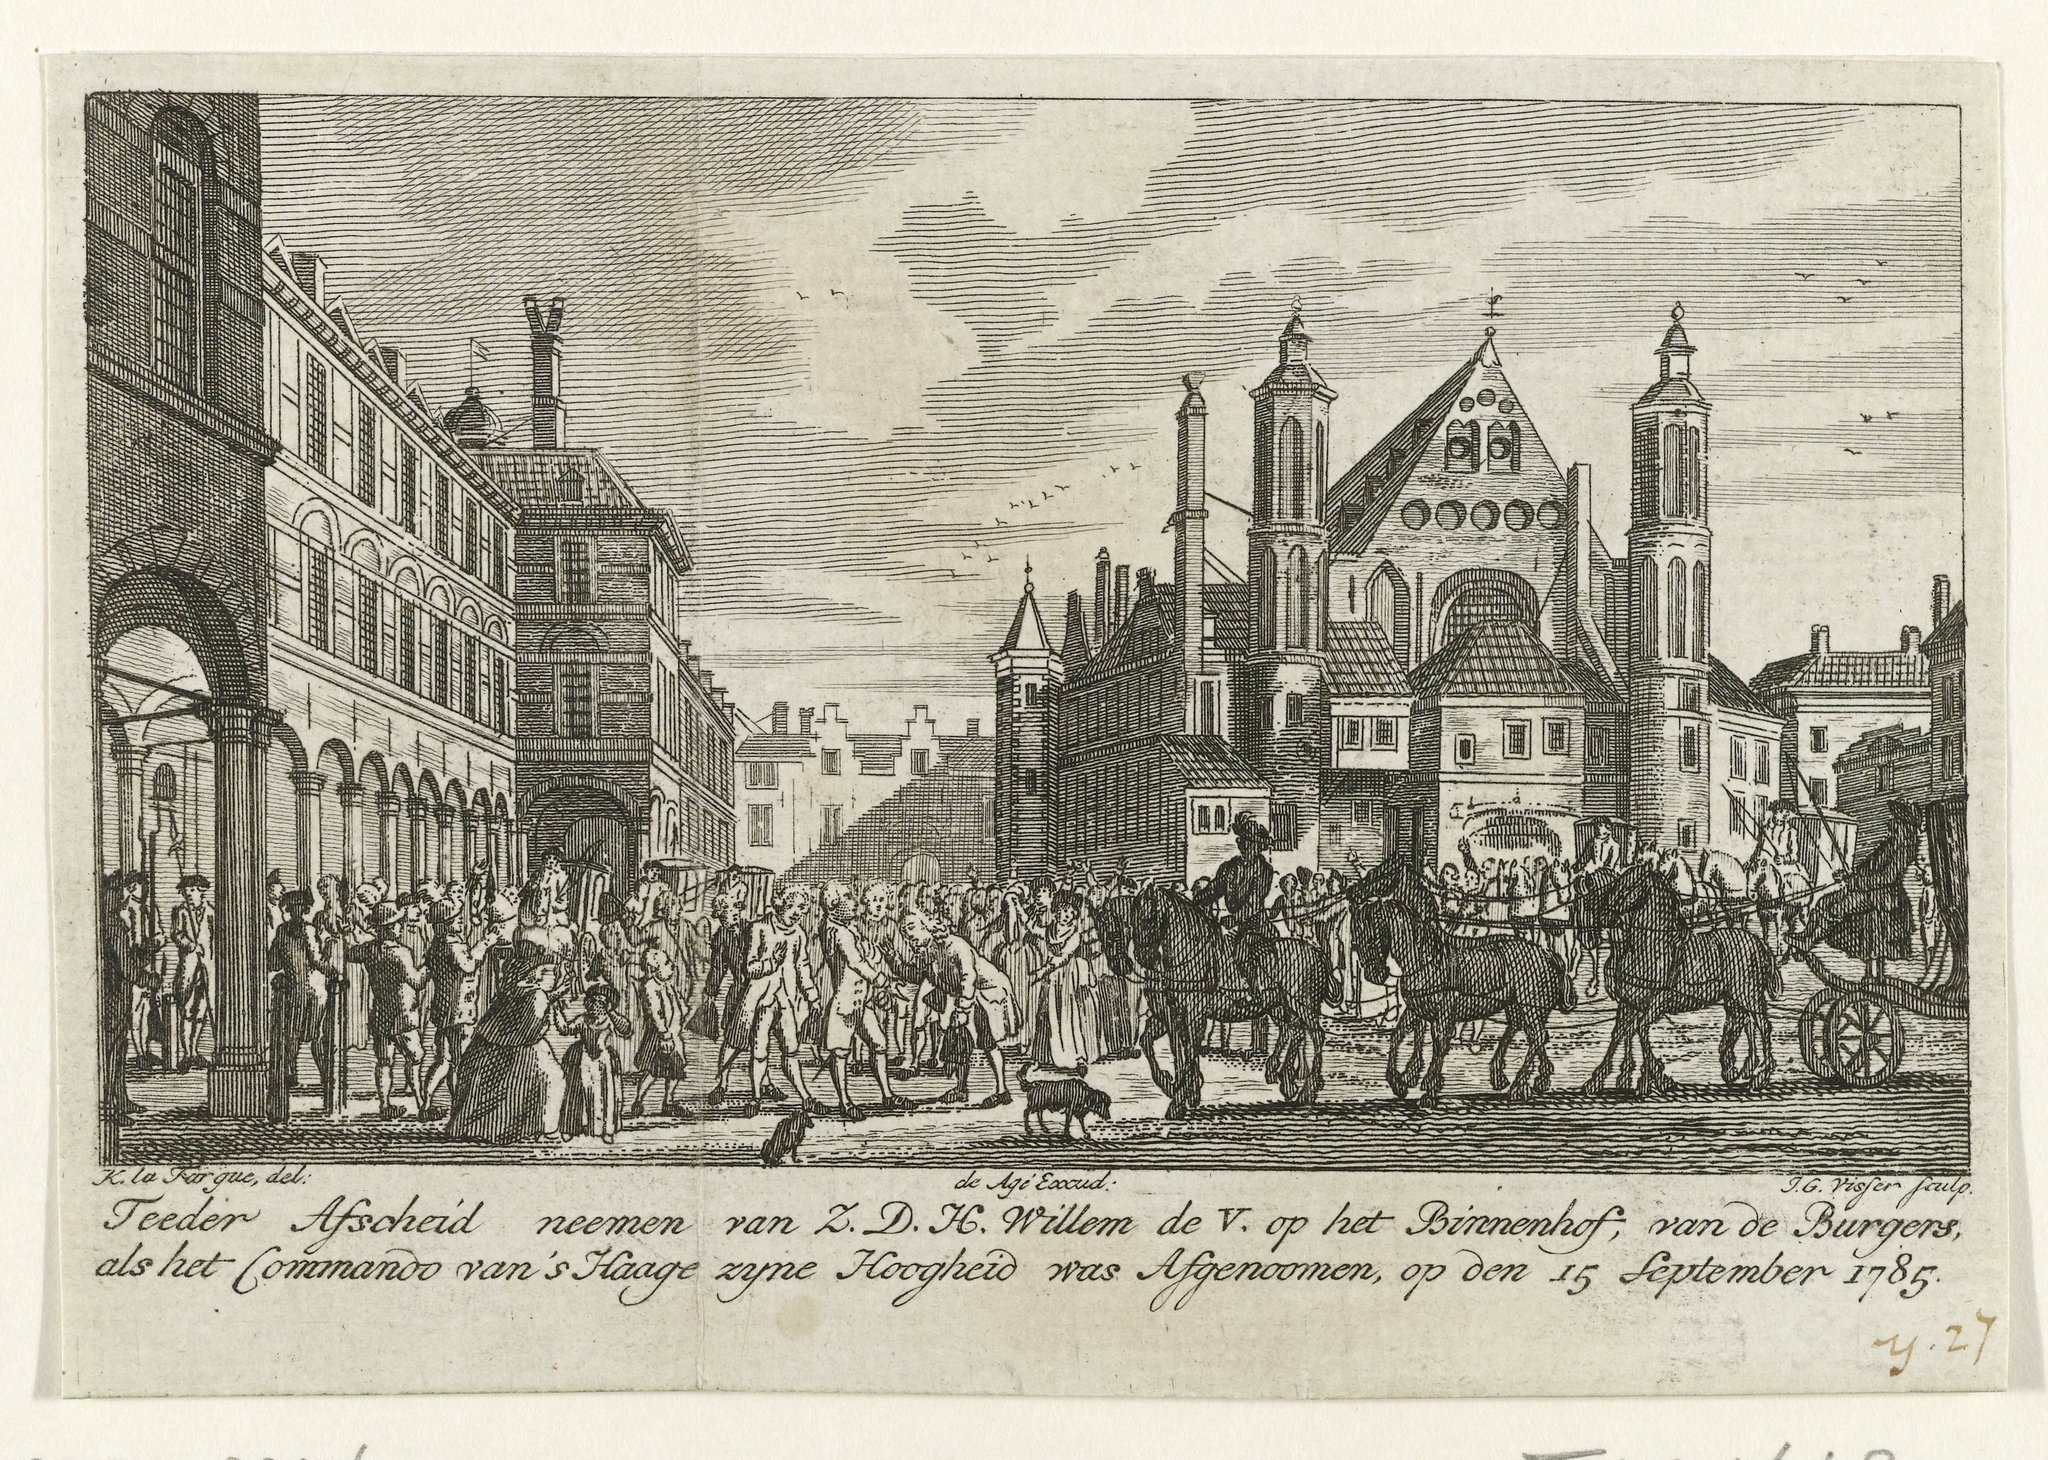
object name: print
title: Willem V neemt afscheid nadat hem het commando over Den Haag is afgenomen, 1785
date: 1785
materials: paper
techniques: etching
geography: northern netherlands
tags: the hague, william v (prince of orange), patriots (1780-1795)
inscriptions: collector's mark: Lugt 2228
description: Stadhouder Willem V neemt afscheid nadat hem het commando over Den Haag is afgenomen, 15 september 1785. Op het Binnenhof voor de Ridderzaal neemt de prins afscheid van burgers bij een voor vertrek gereed staande rijtuig.